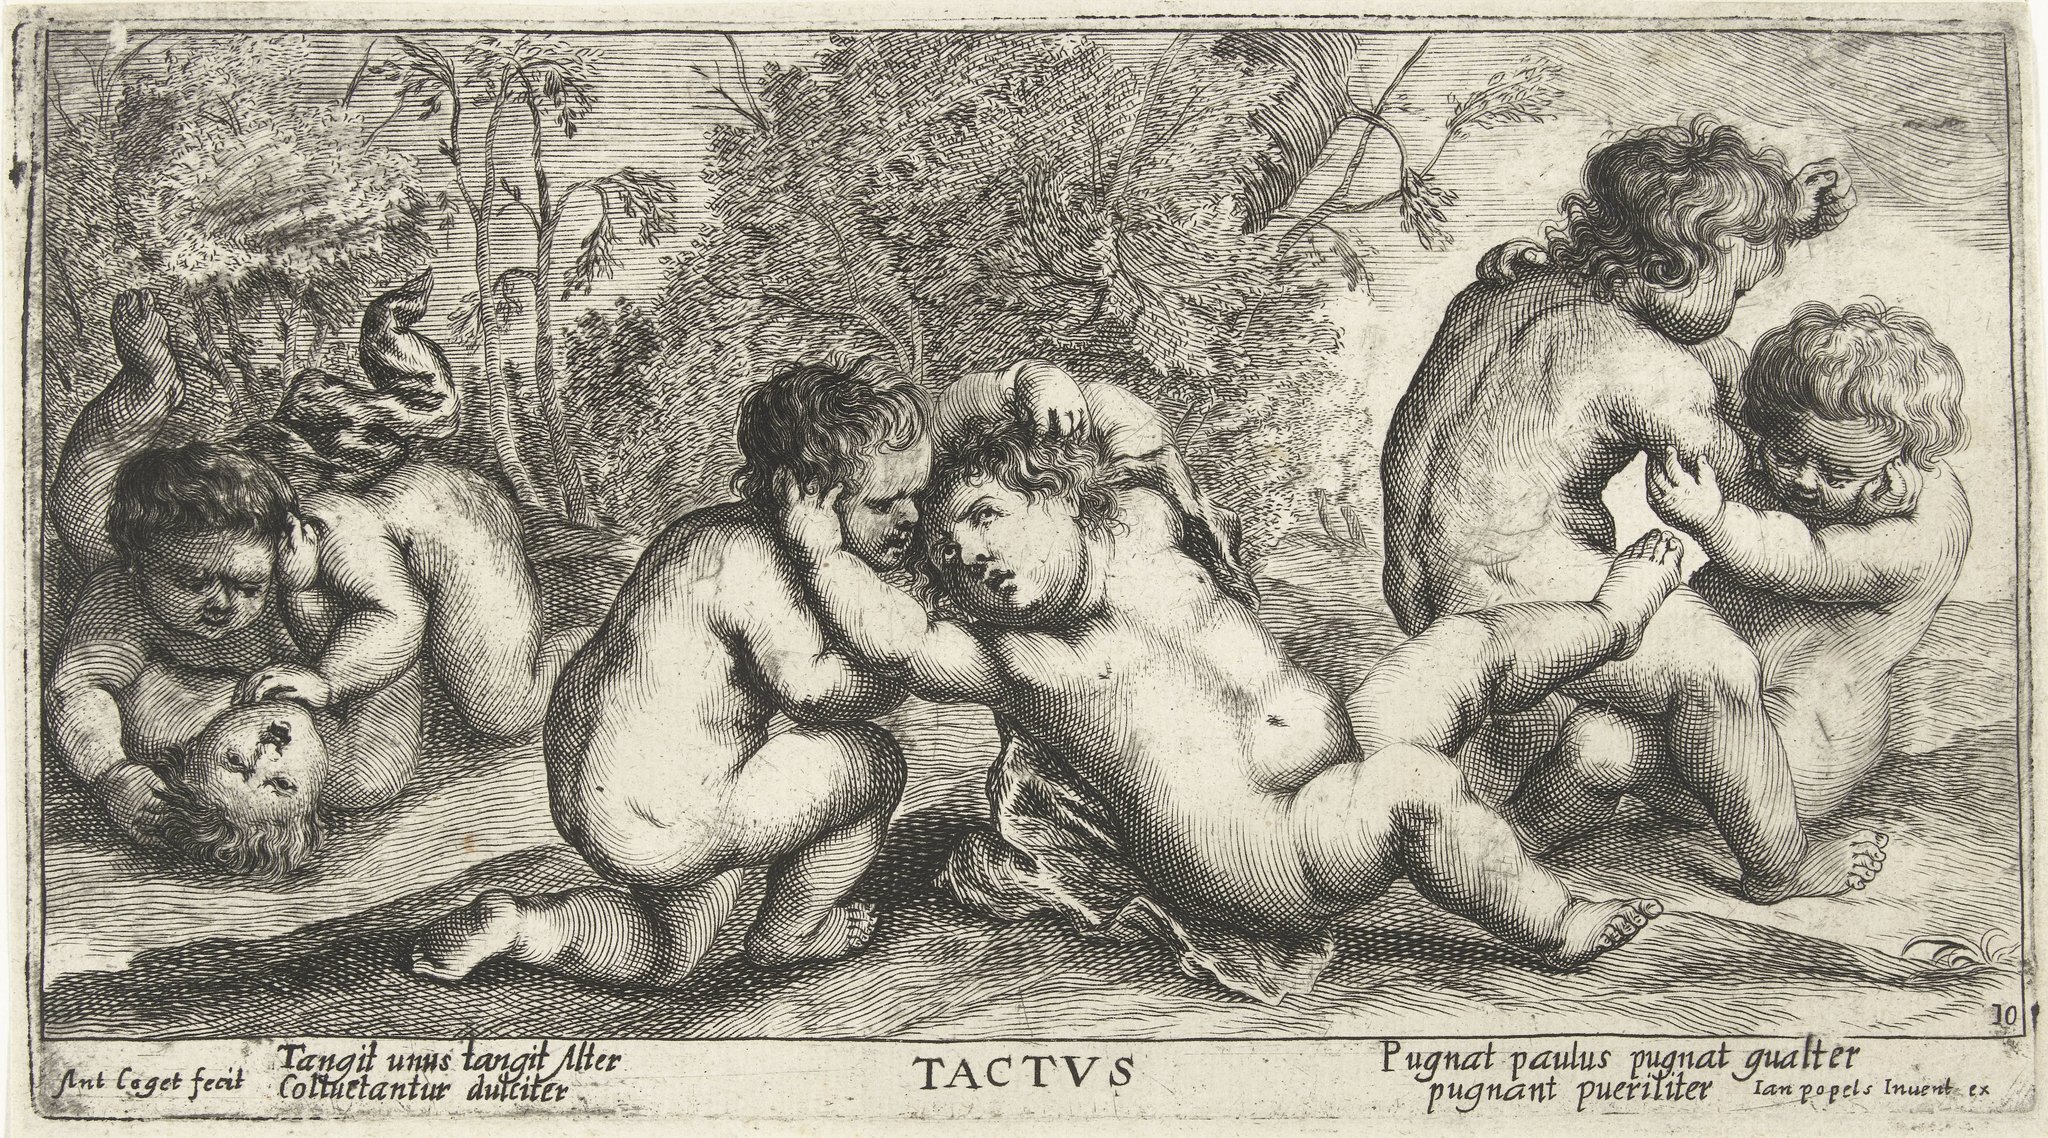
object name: print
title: Crepundia Moralisata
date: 1633-1663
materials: paper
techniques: engraving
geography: antwerp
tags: rough-and-tumble; fighting (+ out of doors (sports, games, etc.)), feeling (one of the five senses)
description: Het titelblad van deze reeks Crepundia Moralisata werd geëtst door Peeter Huybrechts.